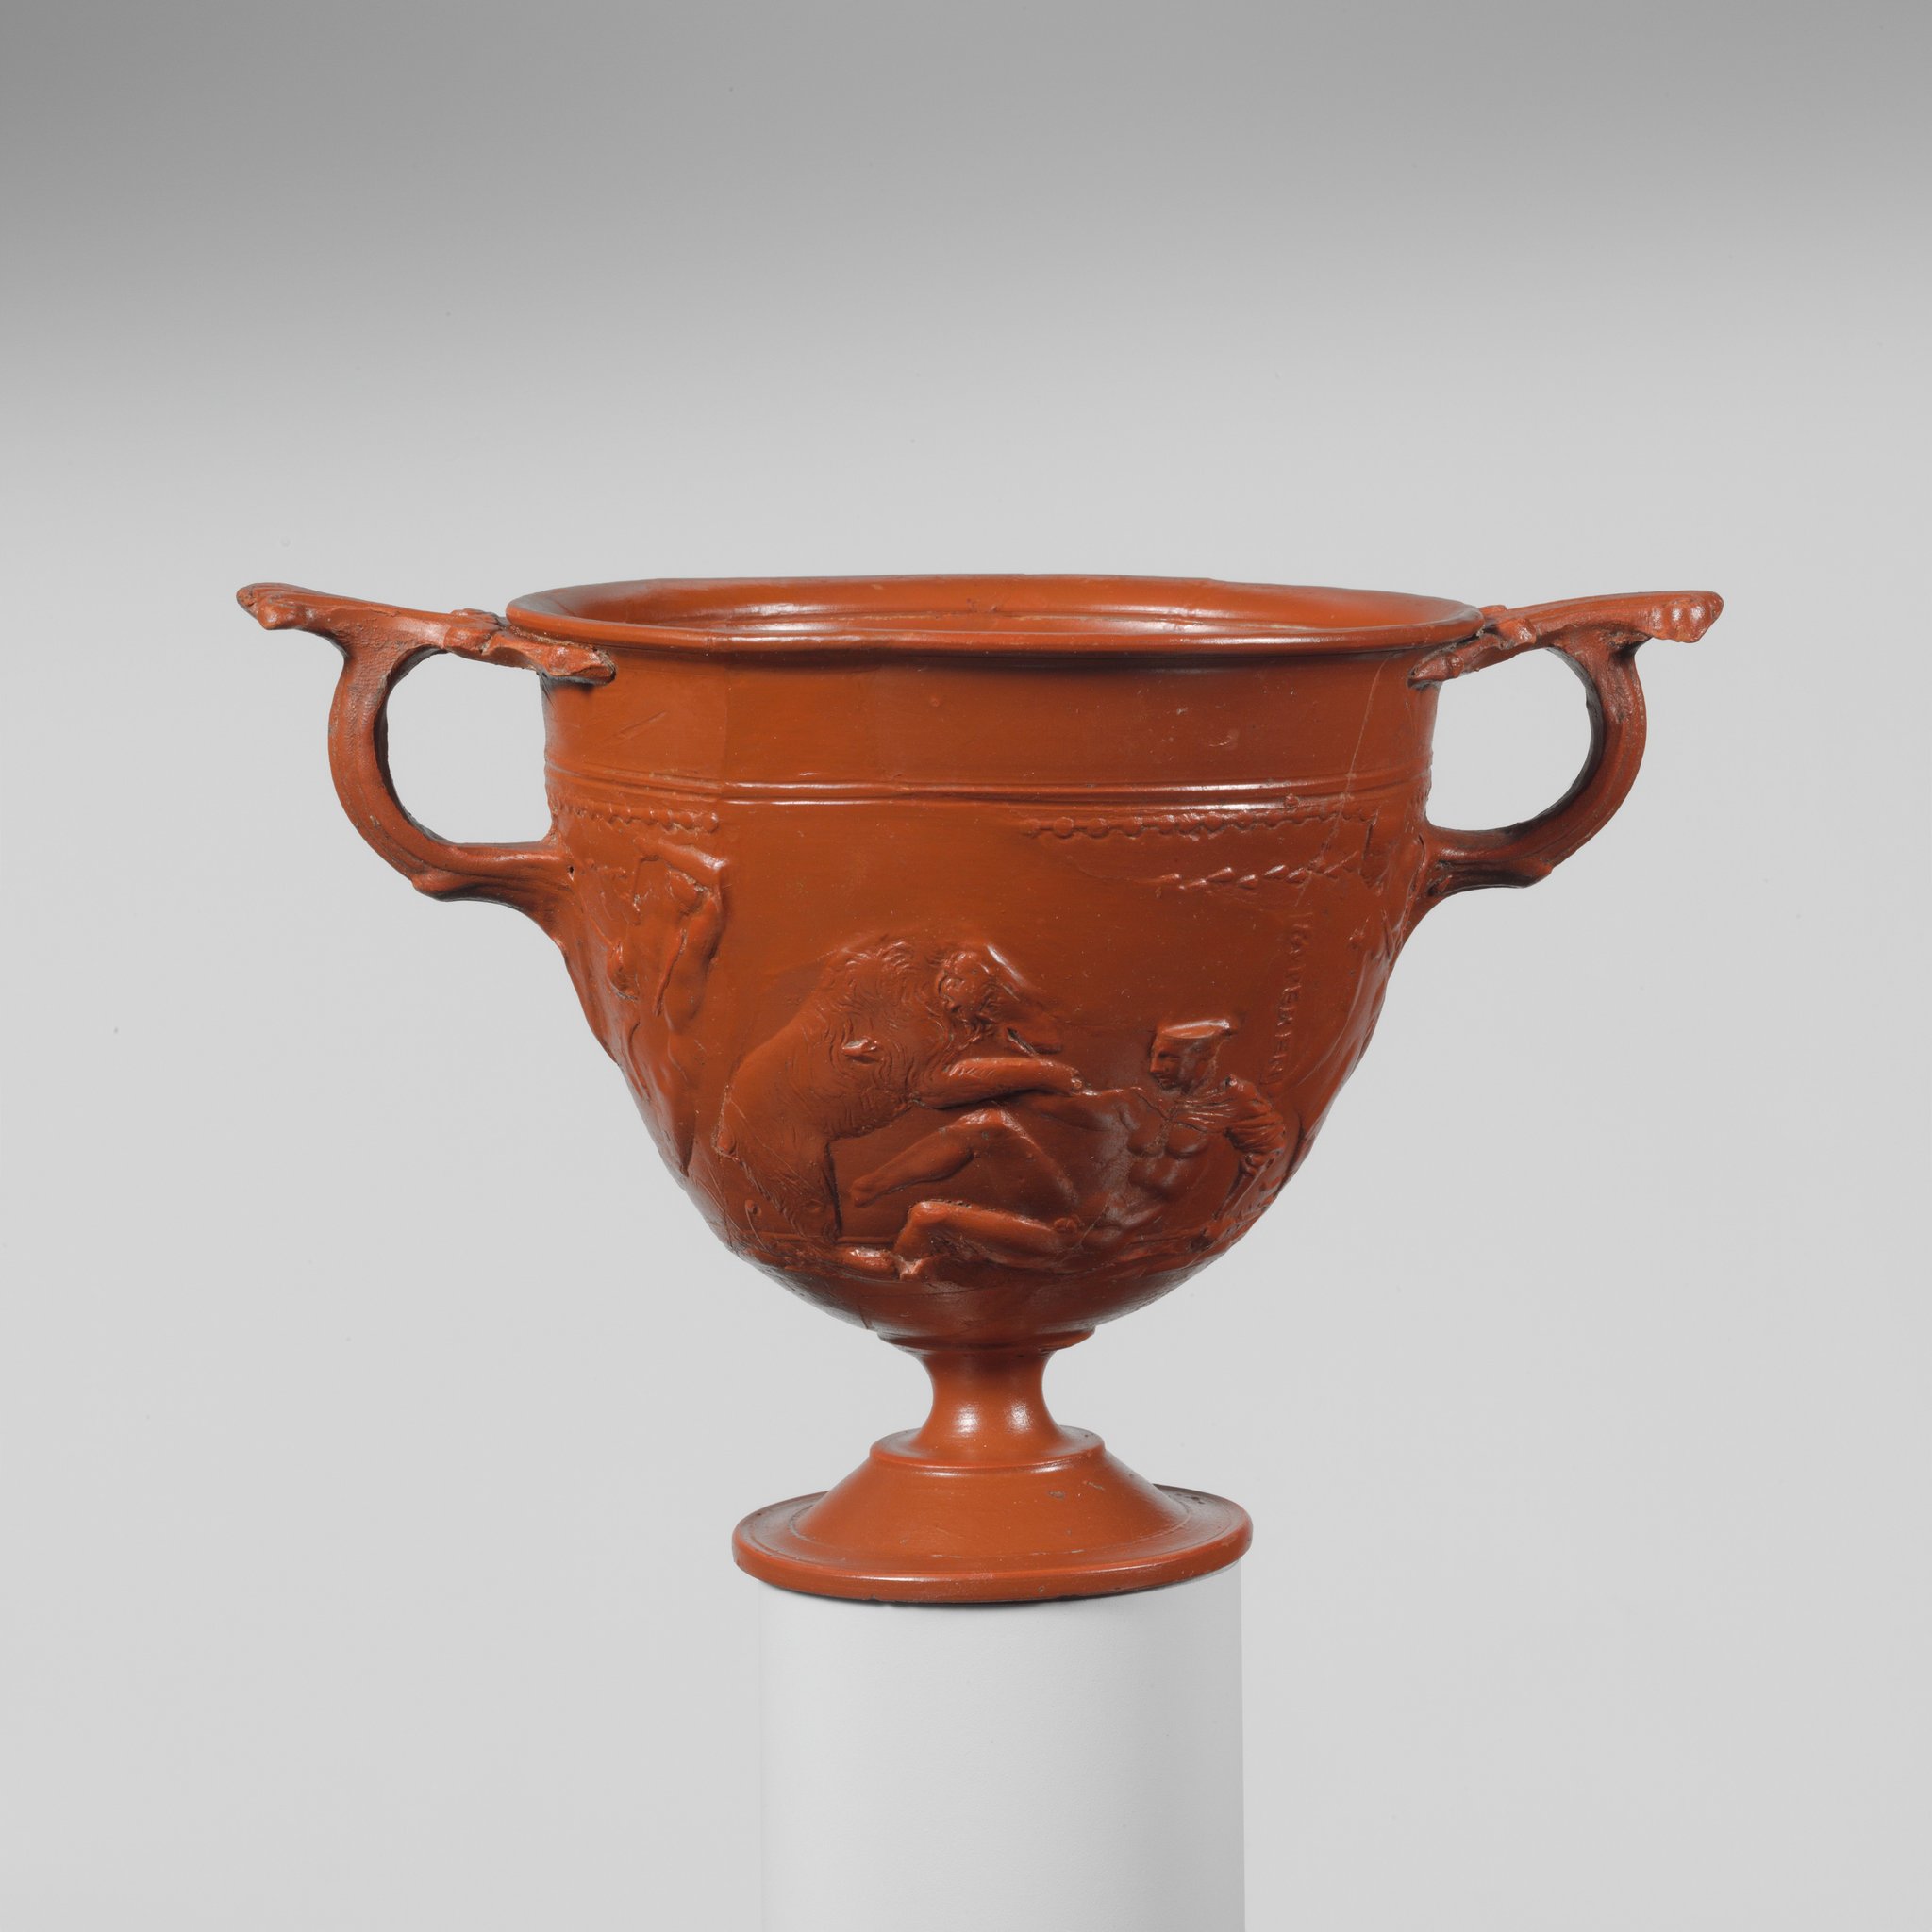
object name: skyphos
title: Terracotta scyphus (drinking cup)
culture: roman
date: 15 BCE-60 CE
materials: terracotta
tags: bears,male nudes,boars